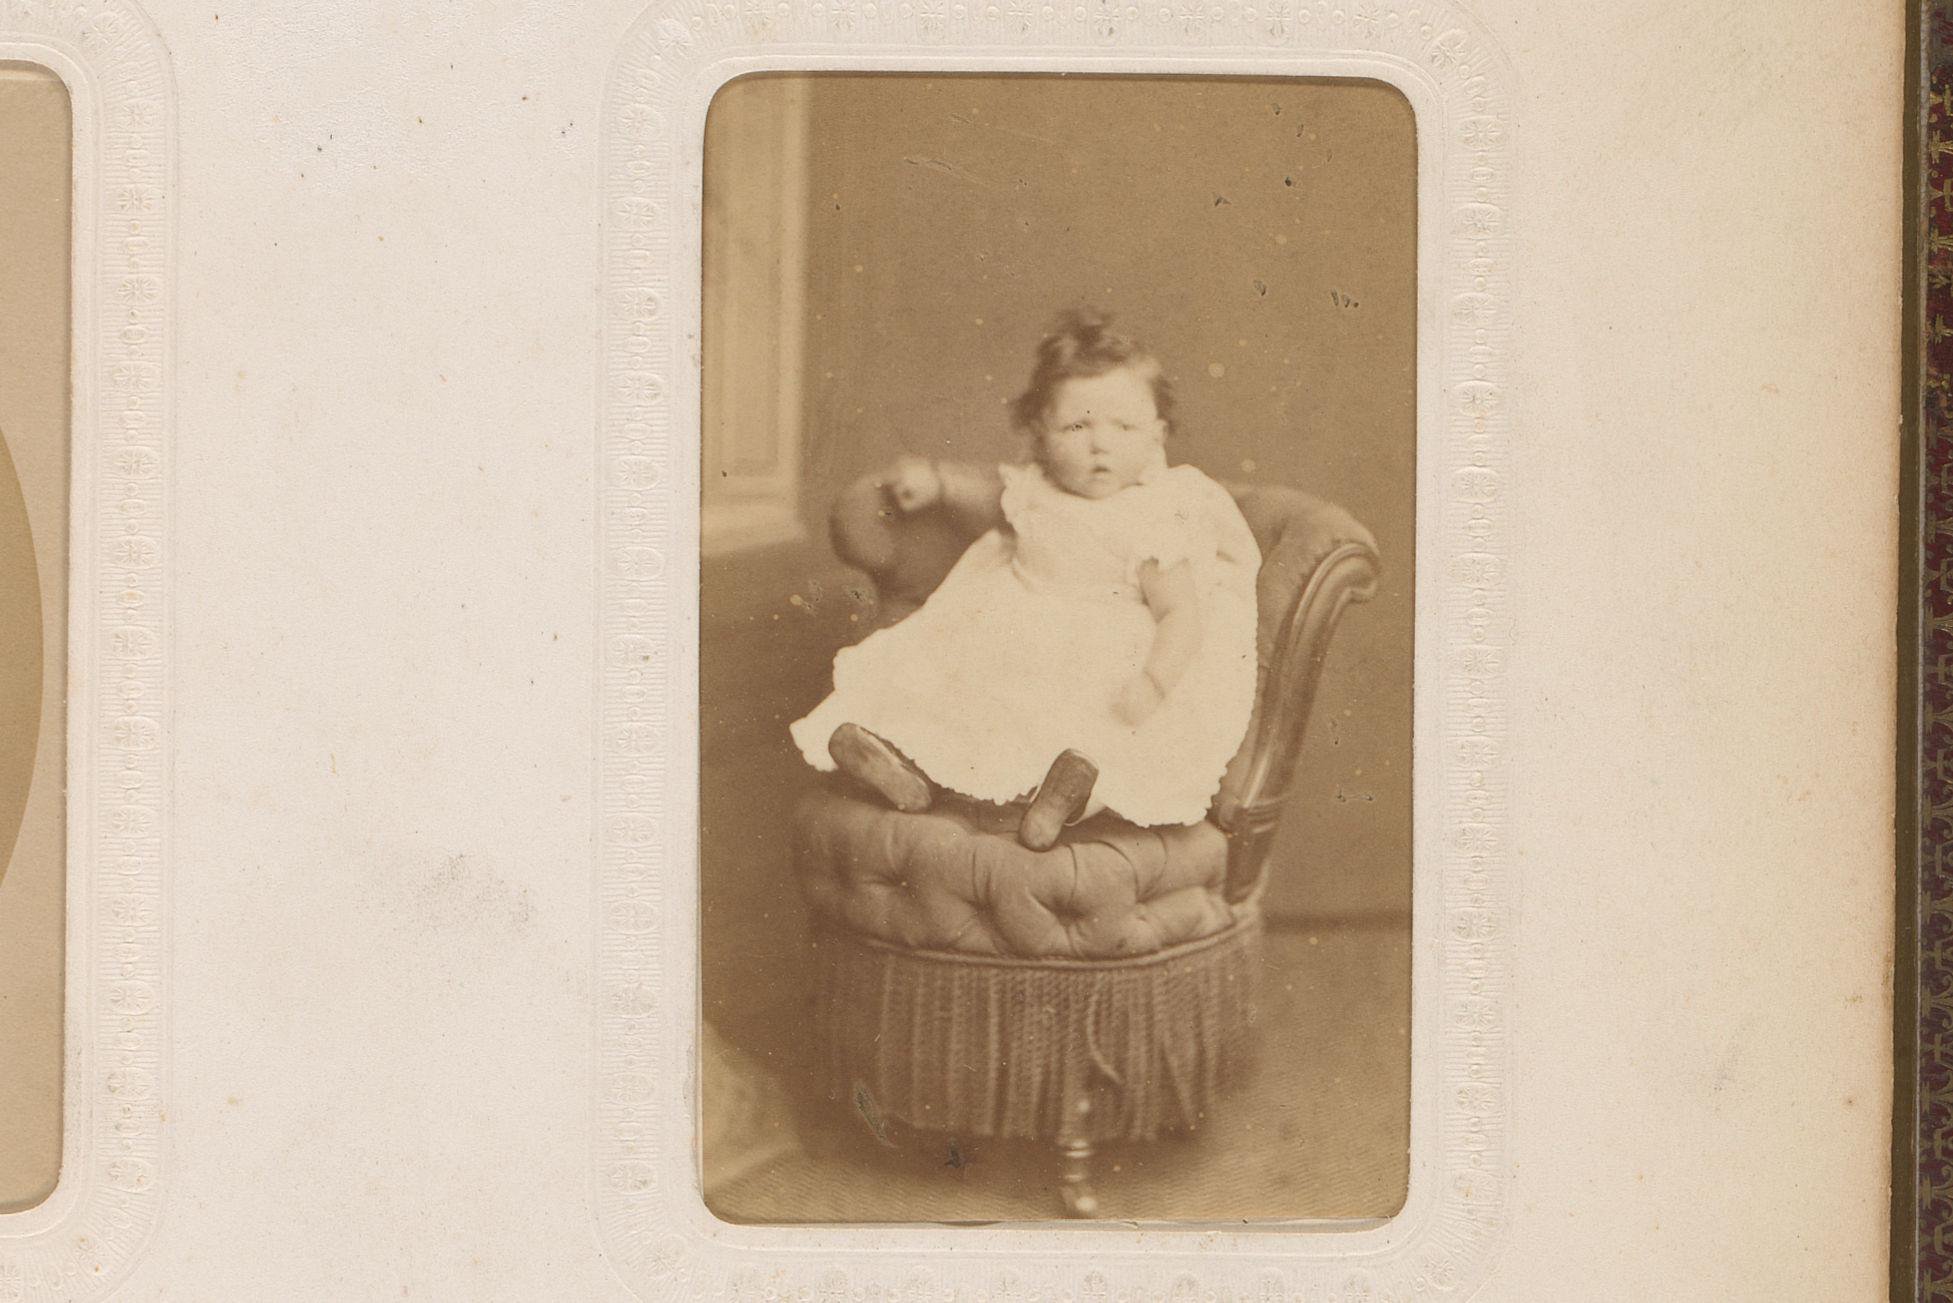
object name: album leaf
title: Portret van een staand meisje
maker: Anonymous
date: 1860-1900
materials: cardboard, photographic support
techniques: albumen print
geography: netherlands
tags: historical persons - bb - woman, girl (child between toddler and youth), standing figure - aa - female human figure